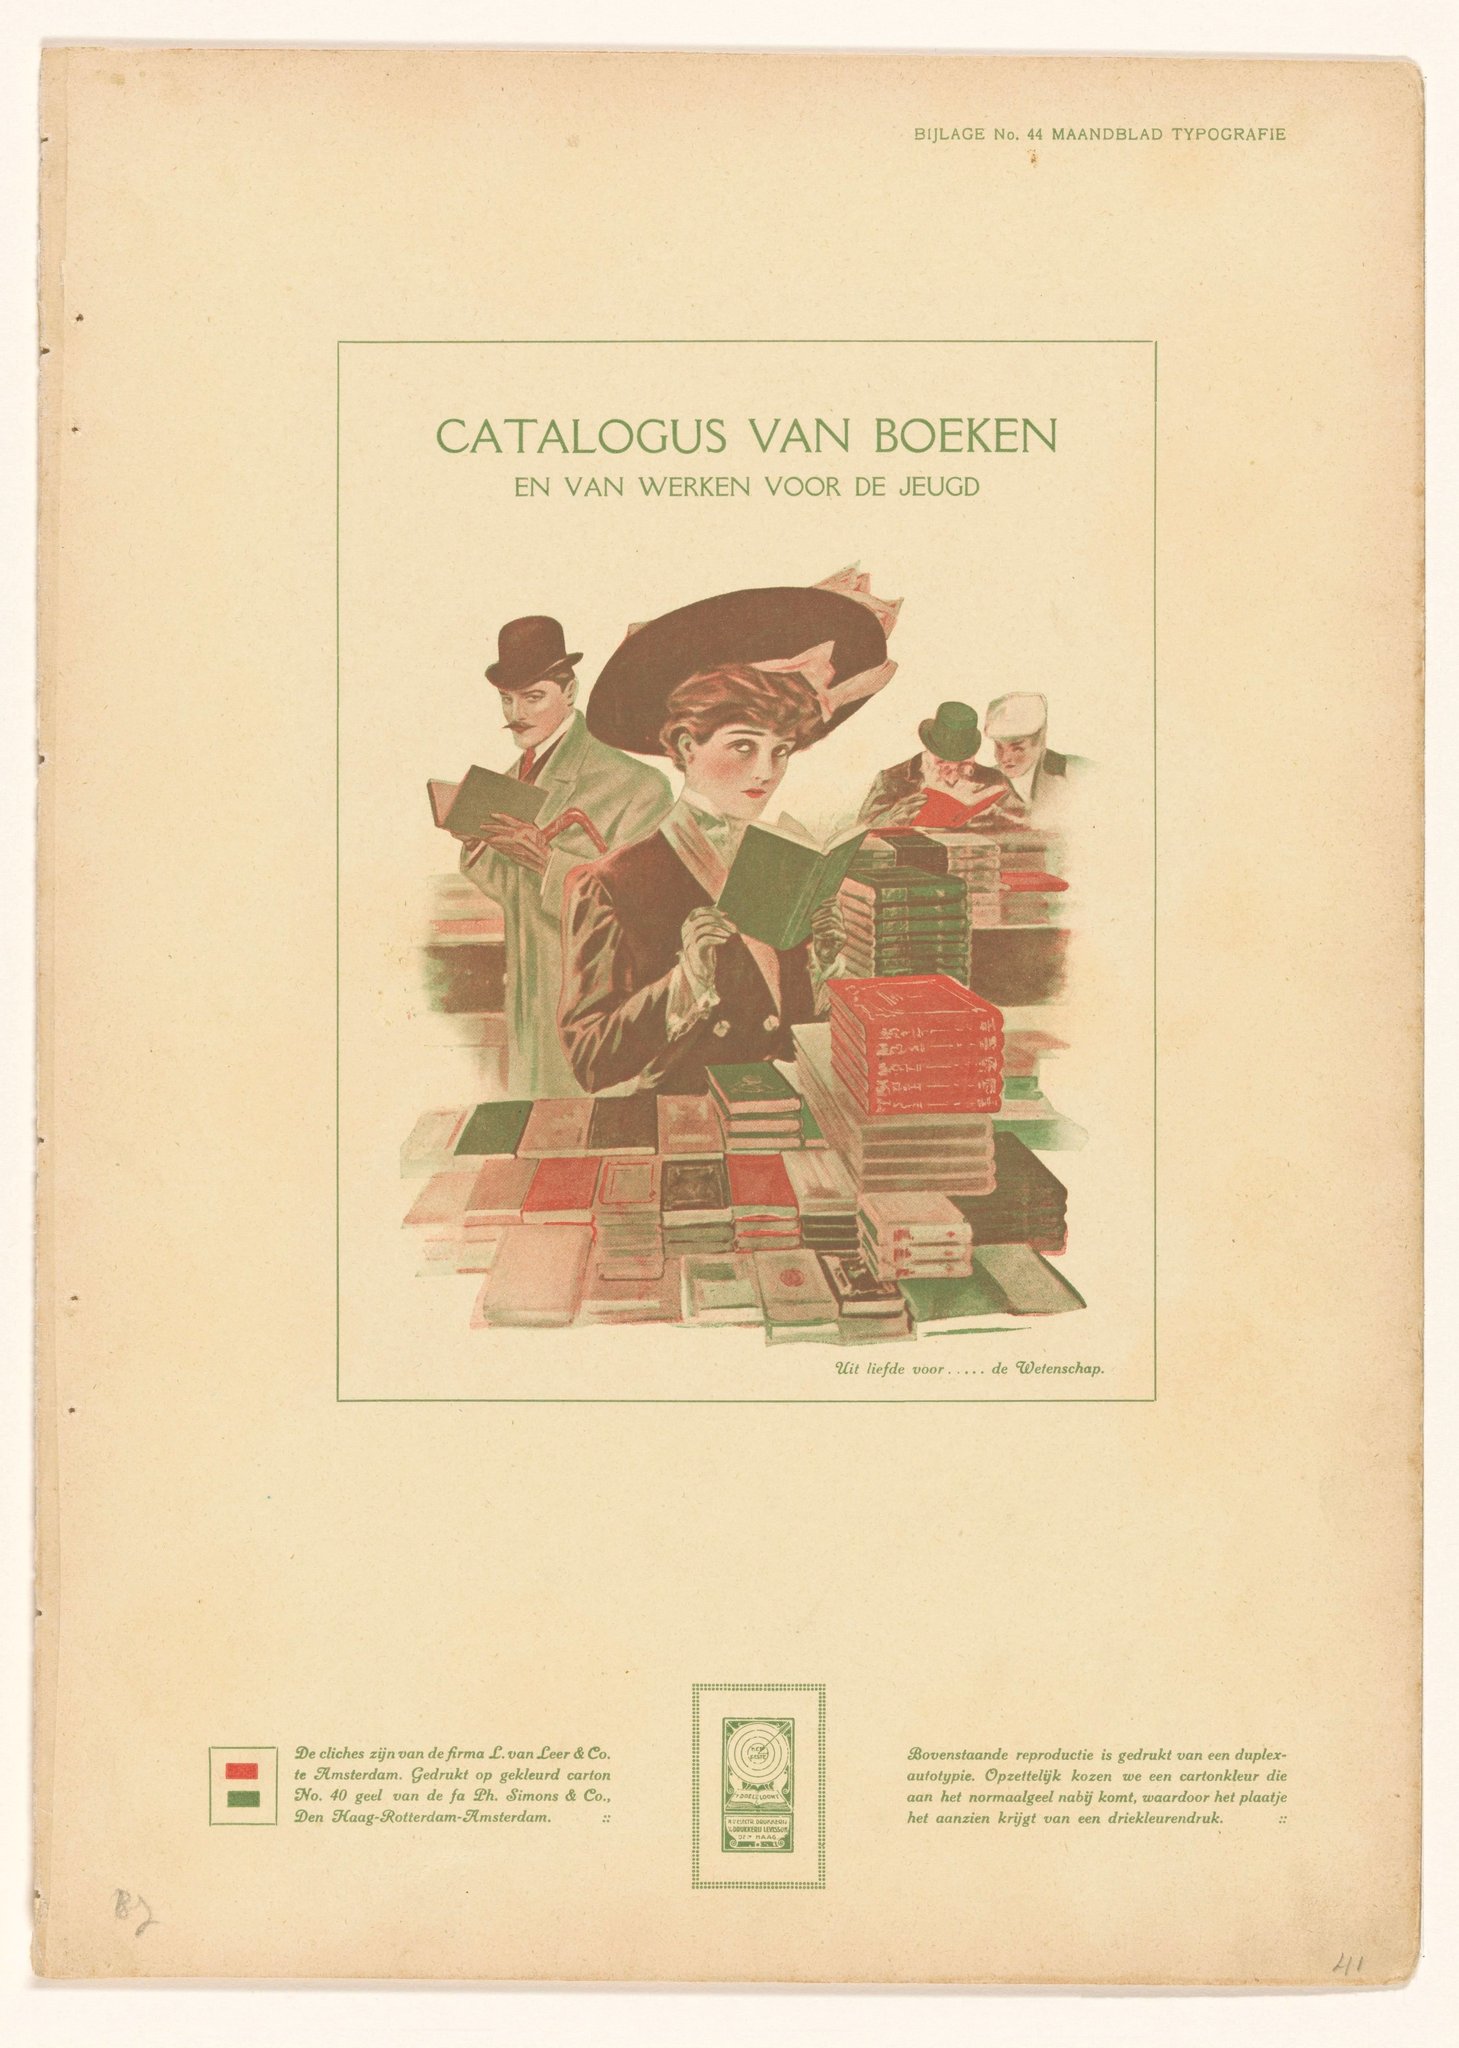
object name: print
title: Klanten in een boekhandel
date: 1900-1930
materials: paper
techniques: two-color autotype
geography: amsterdam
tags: reading, book-shop, bookseller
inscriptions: collector's mark: Lugt 2228, collector's mark: Lugt 4780, collector's mark: Lugt 4779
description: Een man en een vrouw, met boek in de hand, tussen stapels uitgestalde boeken. Op de achtergrond twee mannen gebogen over een boek. In de rechter bovenhoek: Bijlage No. 44 Maandblad Typografie.